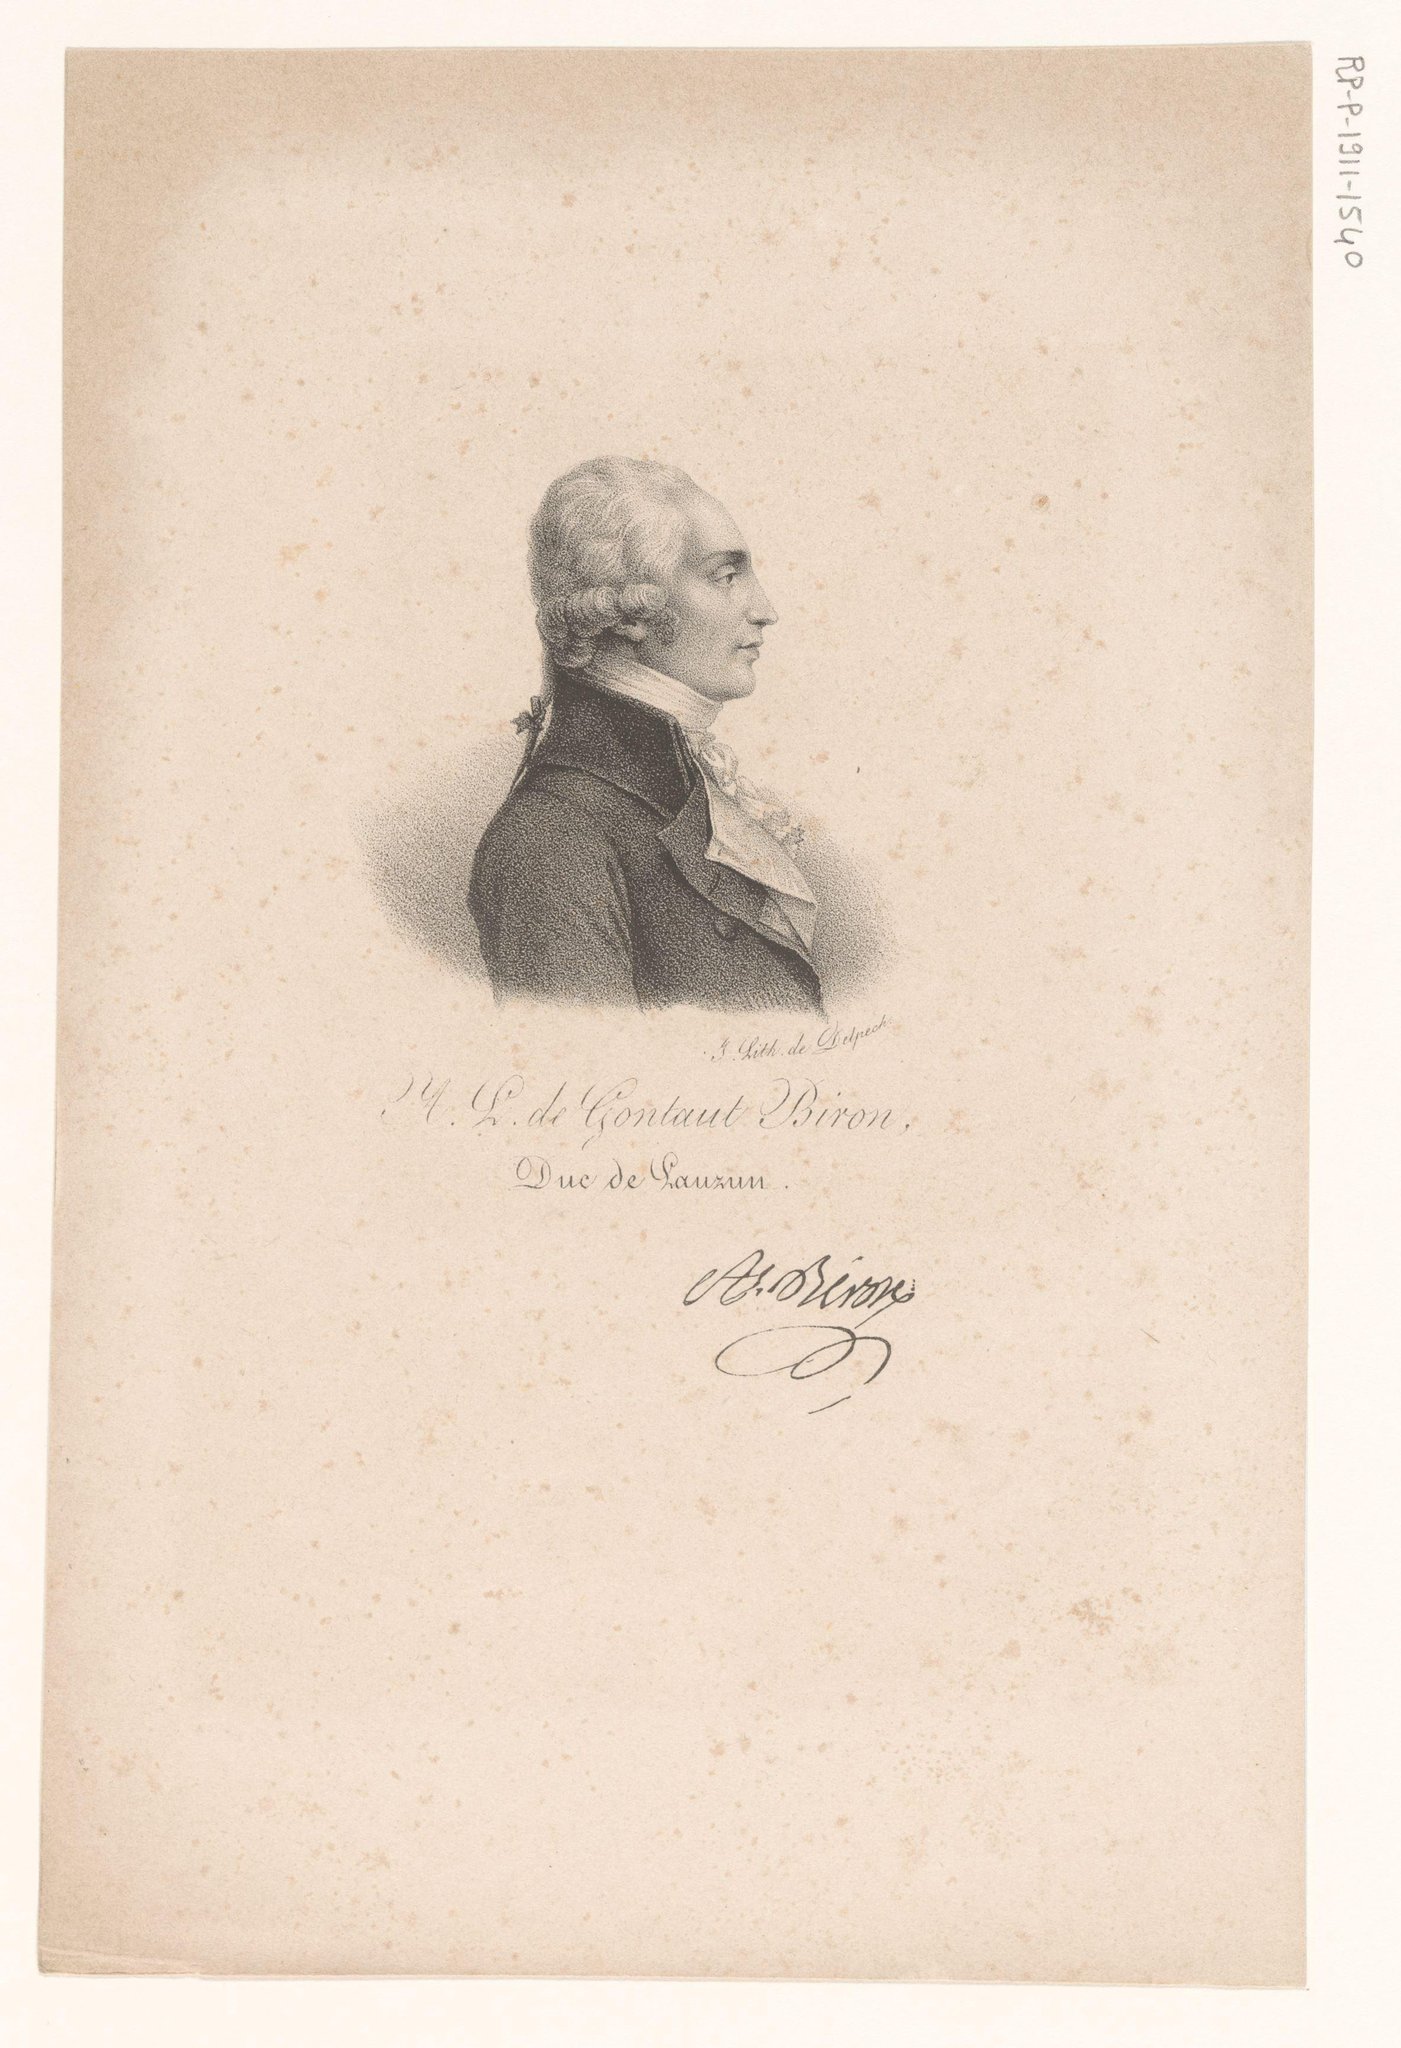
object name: print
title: Portret van Armand-Louis de Gontaut Biron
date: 1818-1842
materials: paper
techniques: lithograph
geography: paris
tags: politician, historical persons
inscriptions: collector's mark: Lugt 2228a